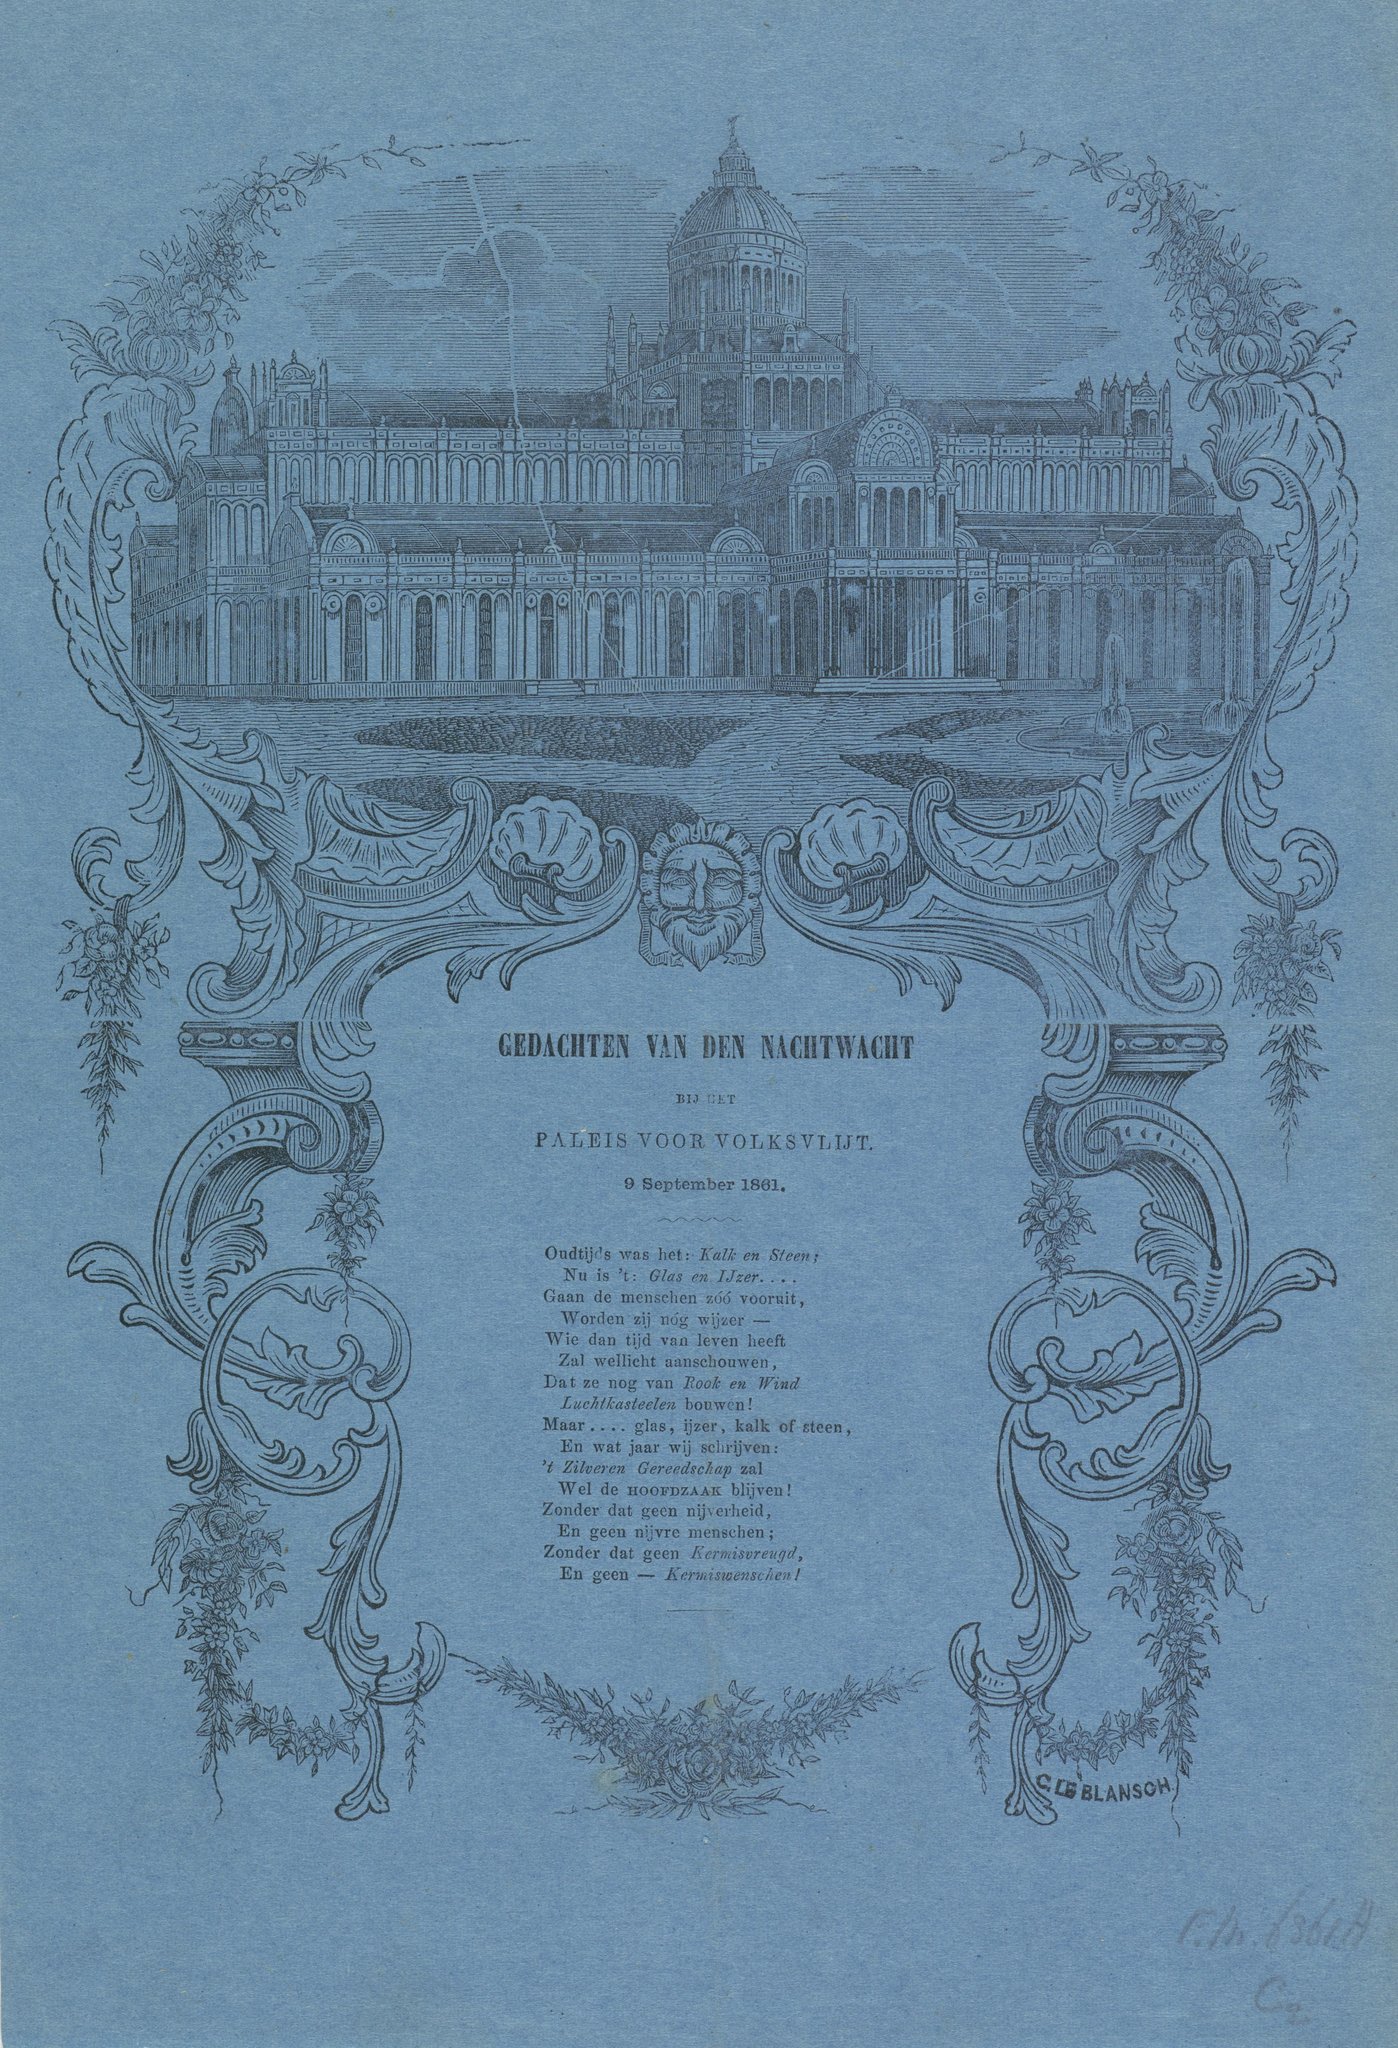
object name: print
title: Kermisprent van de Amsterdamse nachtwacht voor het jaar 1861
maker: christiaan le blansch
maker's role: print maker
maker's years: 1827-1886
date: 1861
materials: paper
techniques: letterpress printing, engraving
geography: netherlands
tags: night patrol, amsterdam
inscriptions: collector's mark: Lugt 2228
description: Kermisprent van de Amsterdamse nachtwacht (ratelwacht), 9 september 1861. Centraal een gedicht, daarboven het Paleis voor Volksvlijt te Amsterdam.